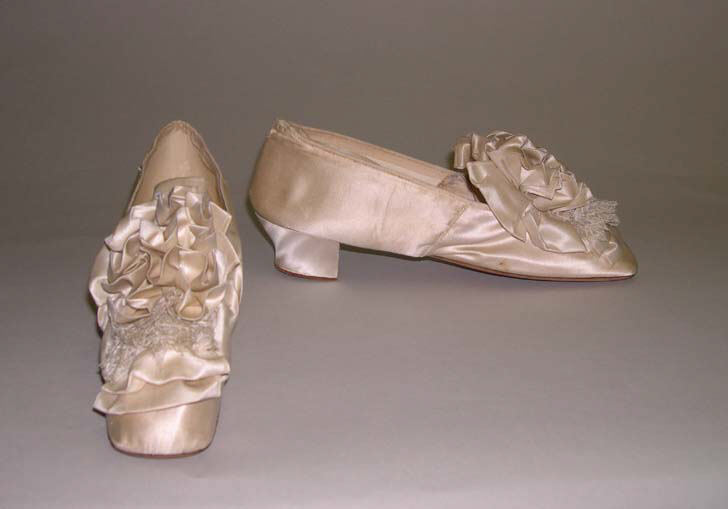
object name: slipper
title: Slippers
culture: french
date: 1872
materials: silk